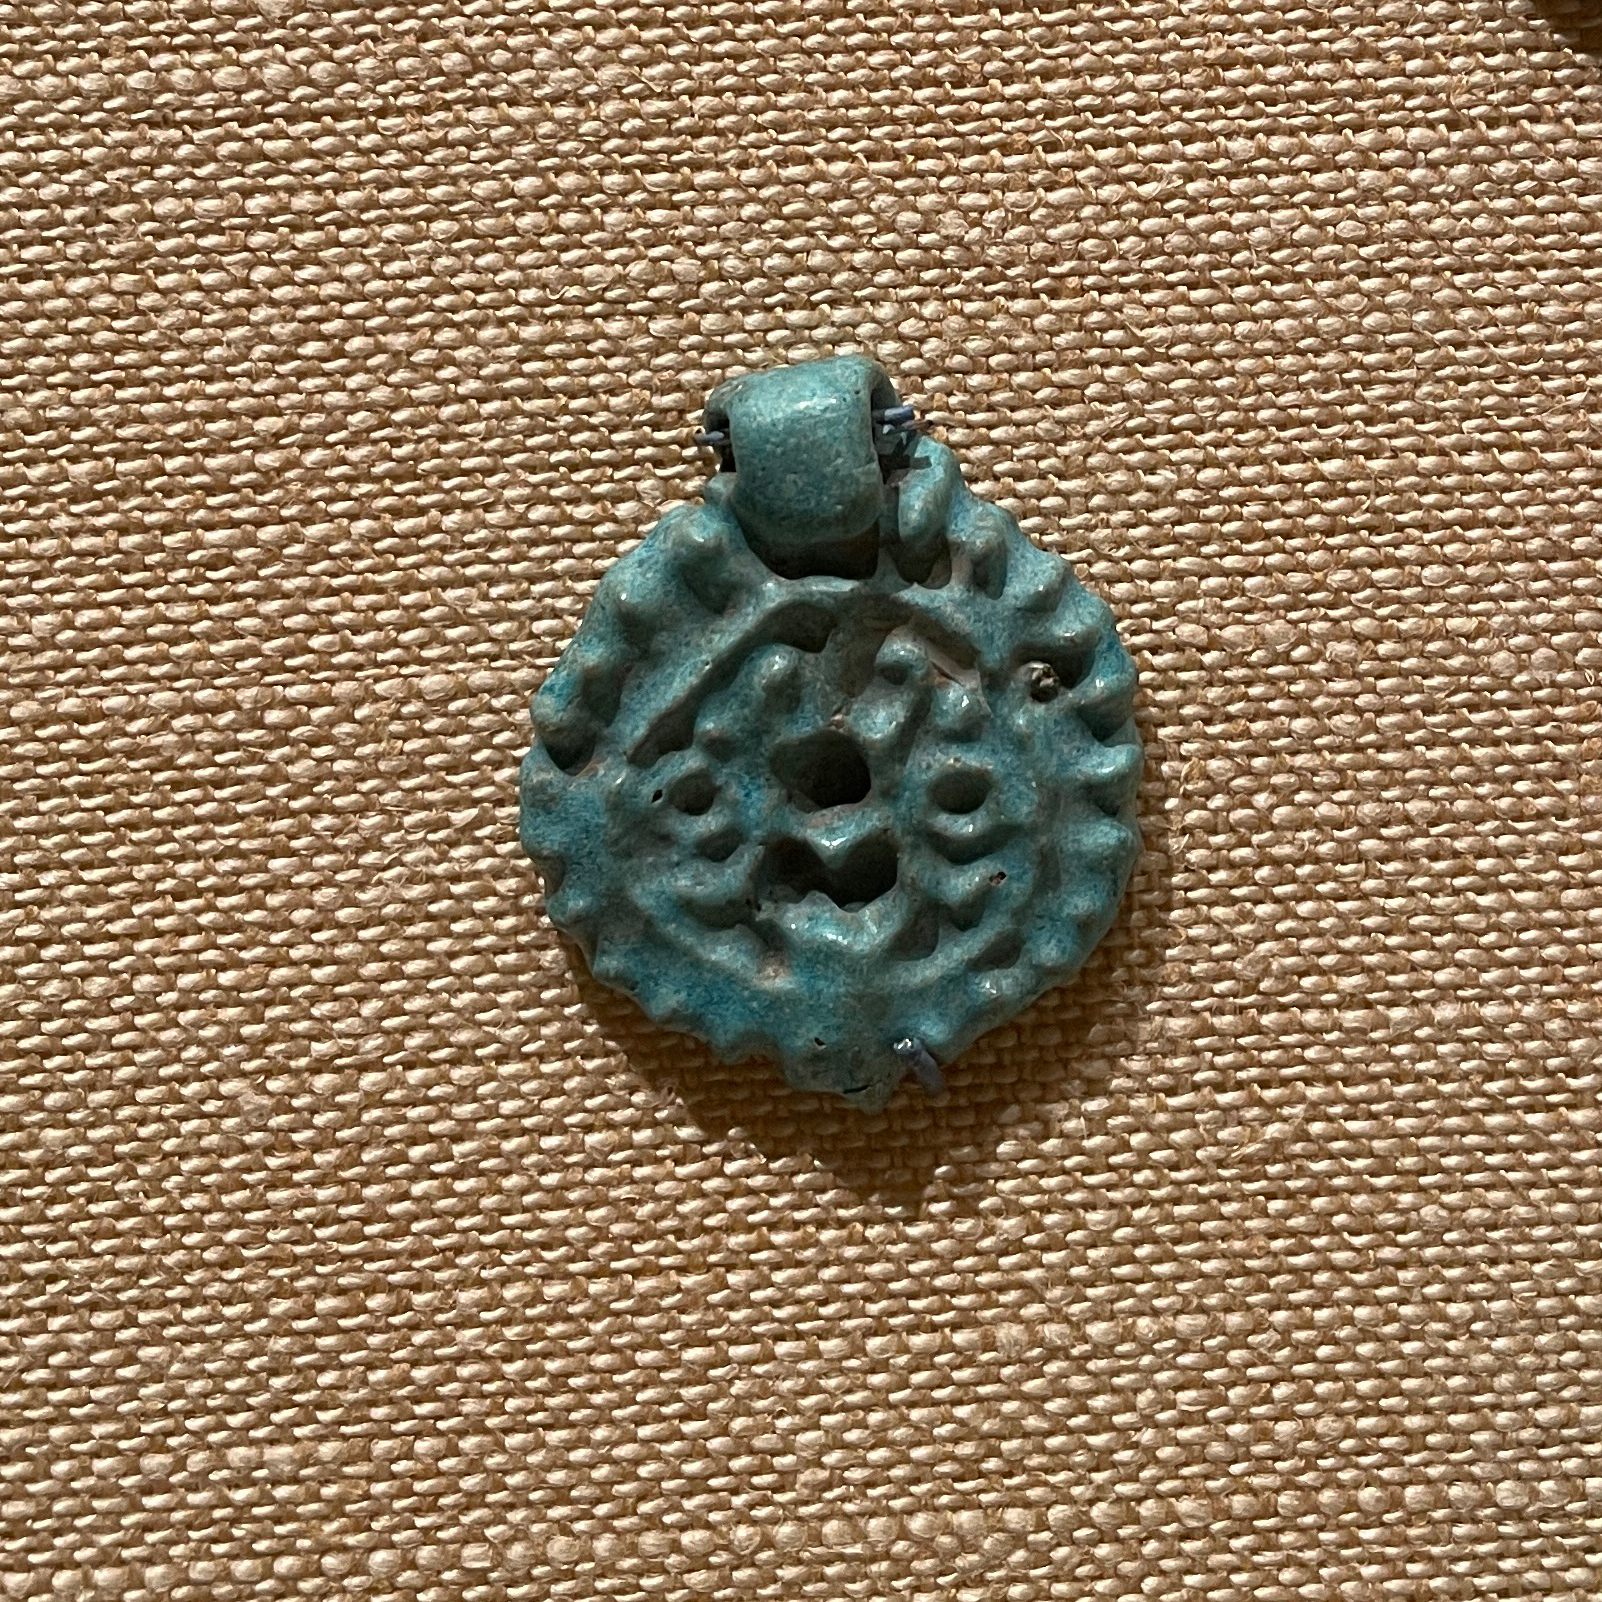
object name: pendant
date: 1001-1100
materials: earthenware, glaze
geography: iran